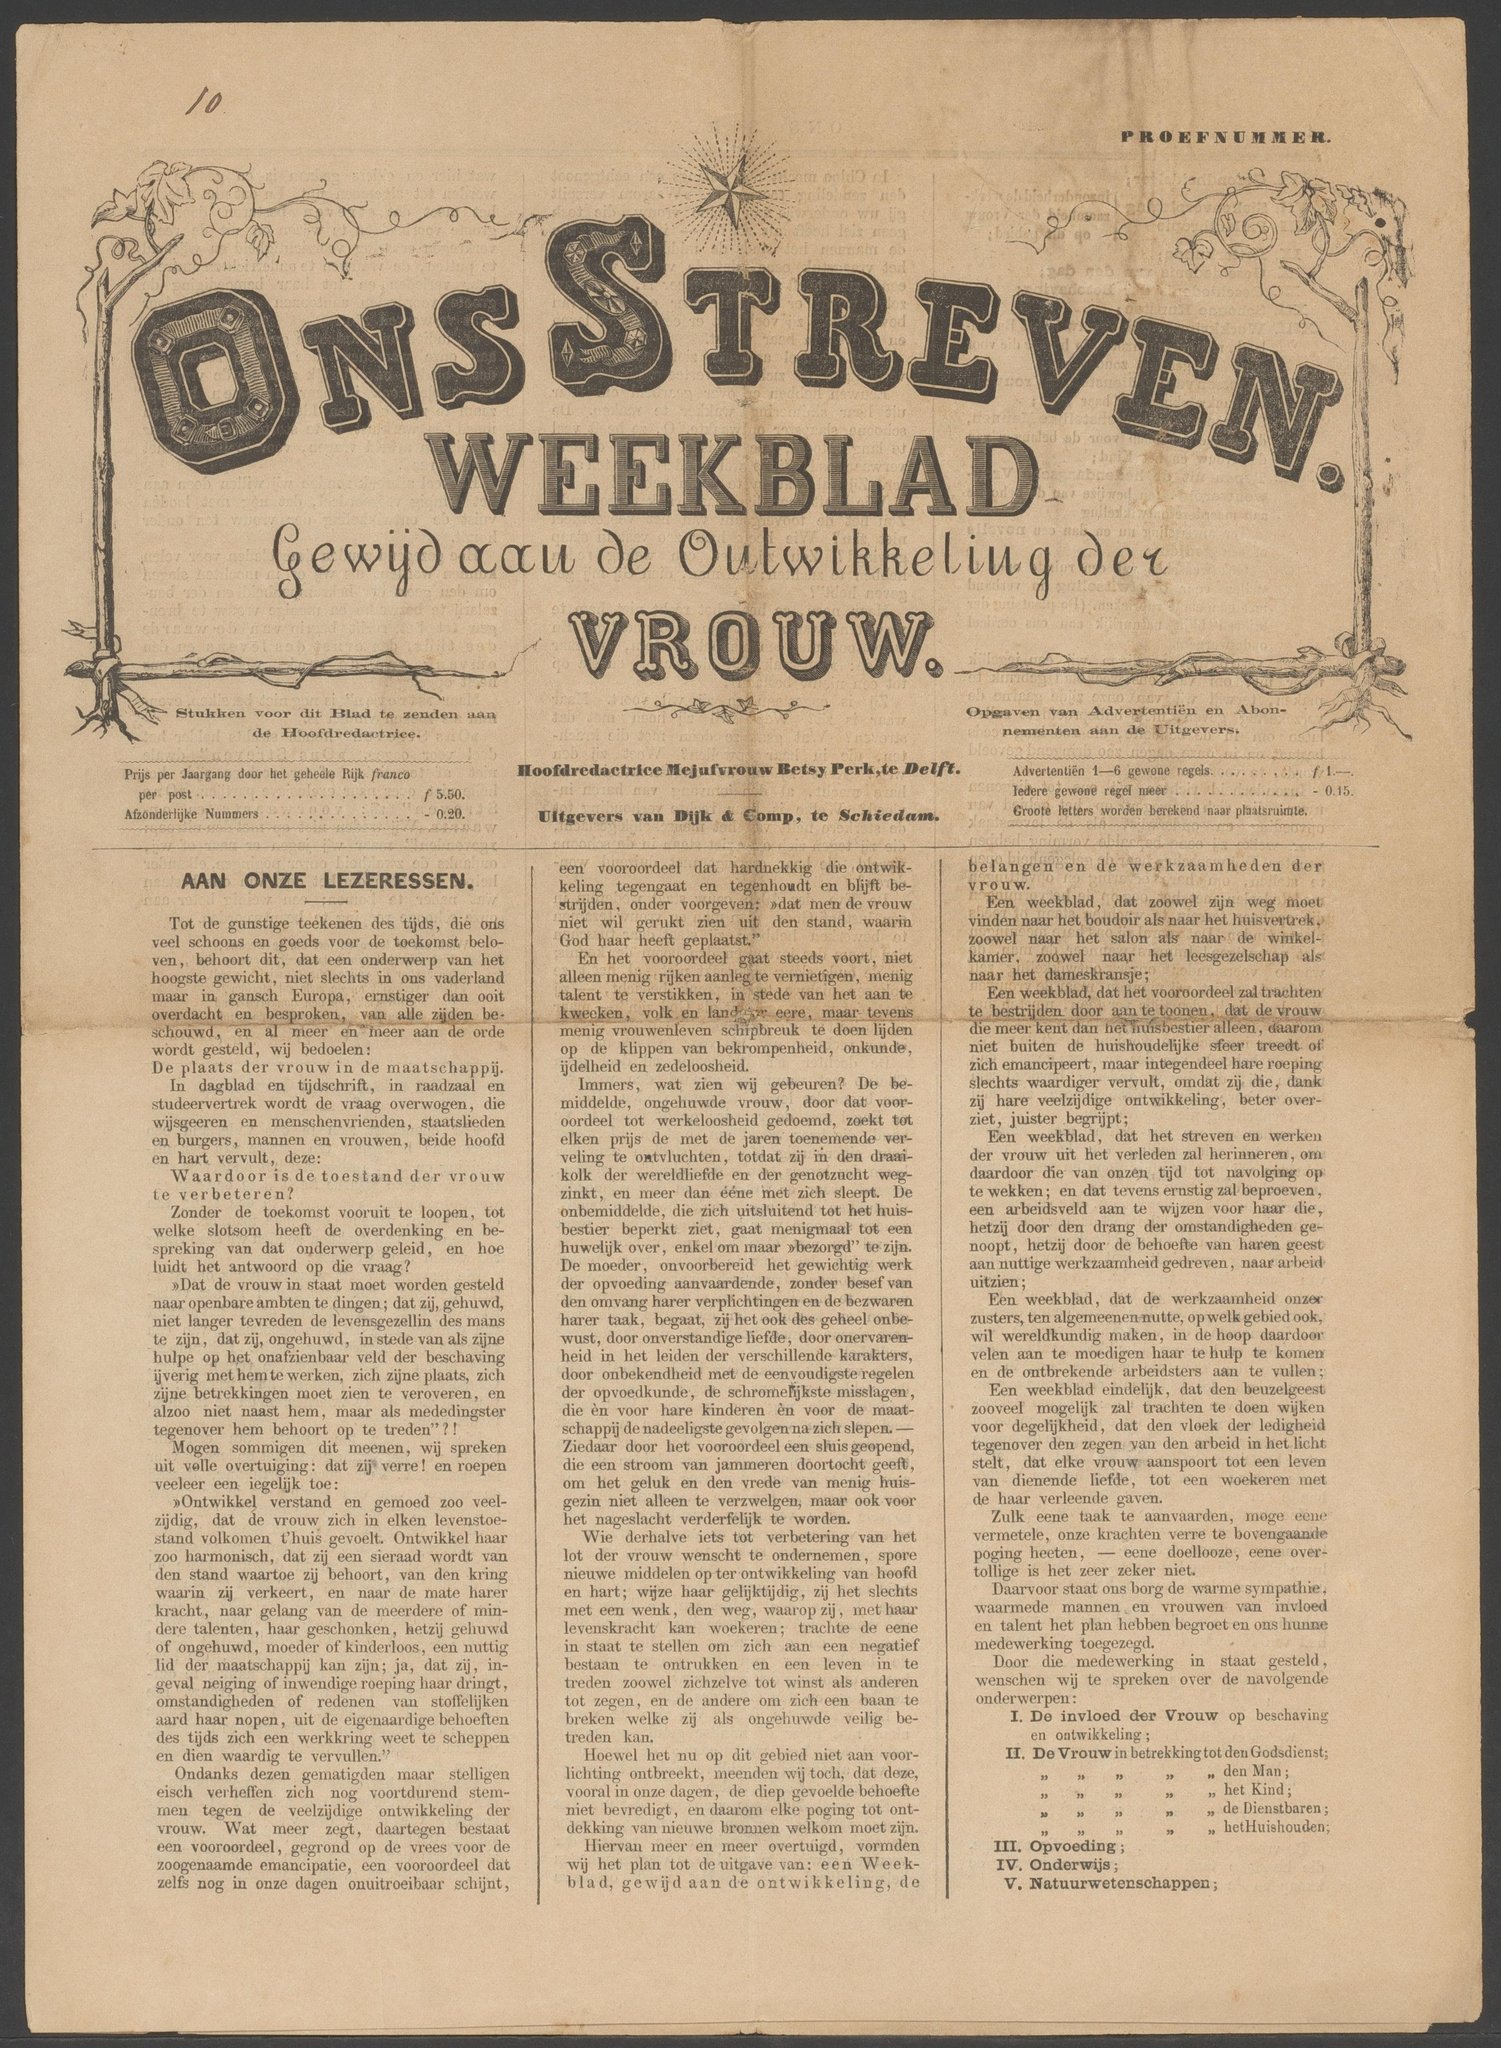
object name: newspaper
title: Ons Streven. Weekblad Gewijd aan de Ontwikkeling der Vrouw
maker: christina elizabeth perk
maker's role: painter, sculptor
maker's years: 1833-1906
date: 1870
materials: paper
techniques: letterpress printing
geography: delft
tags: newspaper, news-sheet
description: Proefnummer van het blad 'Ons Streven. Weekblad Gewijd aan de Ontwikkeling der Vrouw', 1870. Hoofdredactie: Mej. Betsy Perk, te Delft. De titel tussen enkele takken en ranken. Dubbelbladig, alle zijden bedrukt. Onderwerpsrubrieken binnen de Atlas Zeden en Gewoonten: Regeering, Officieele Nieuwsbladen.